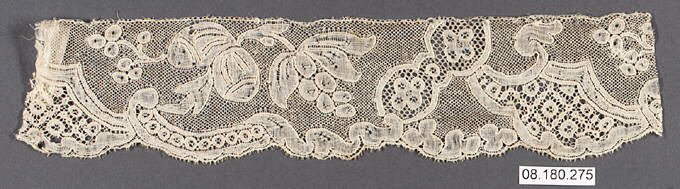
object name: fragment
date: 1701-1800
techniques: lace